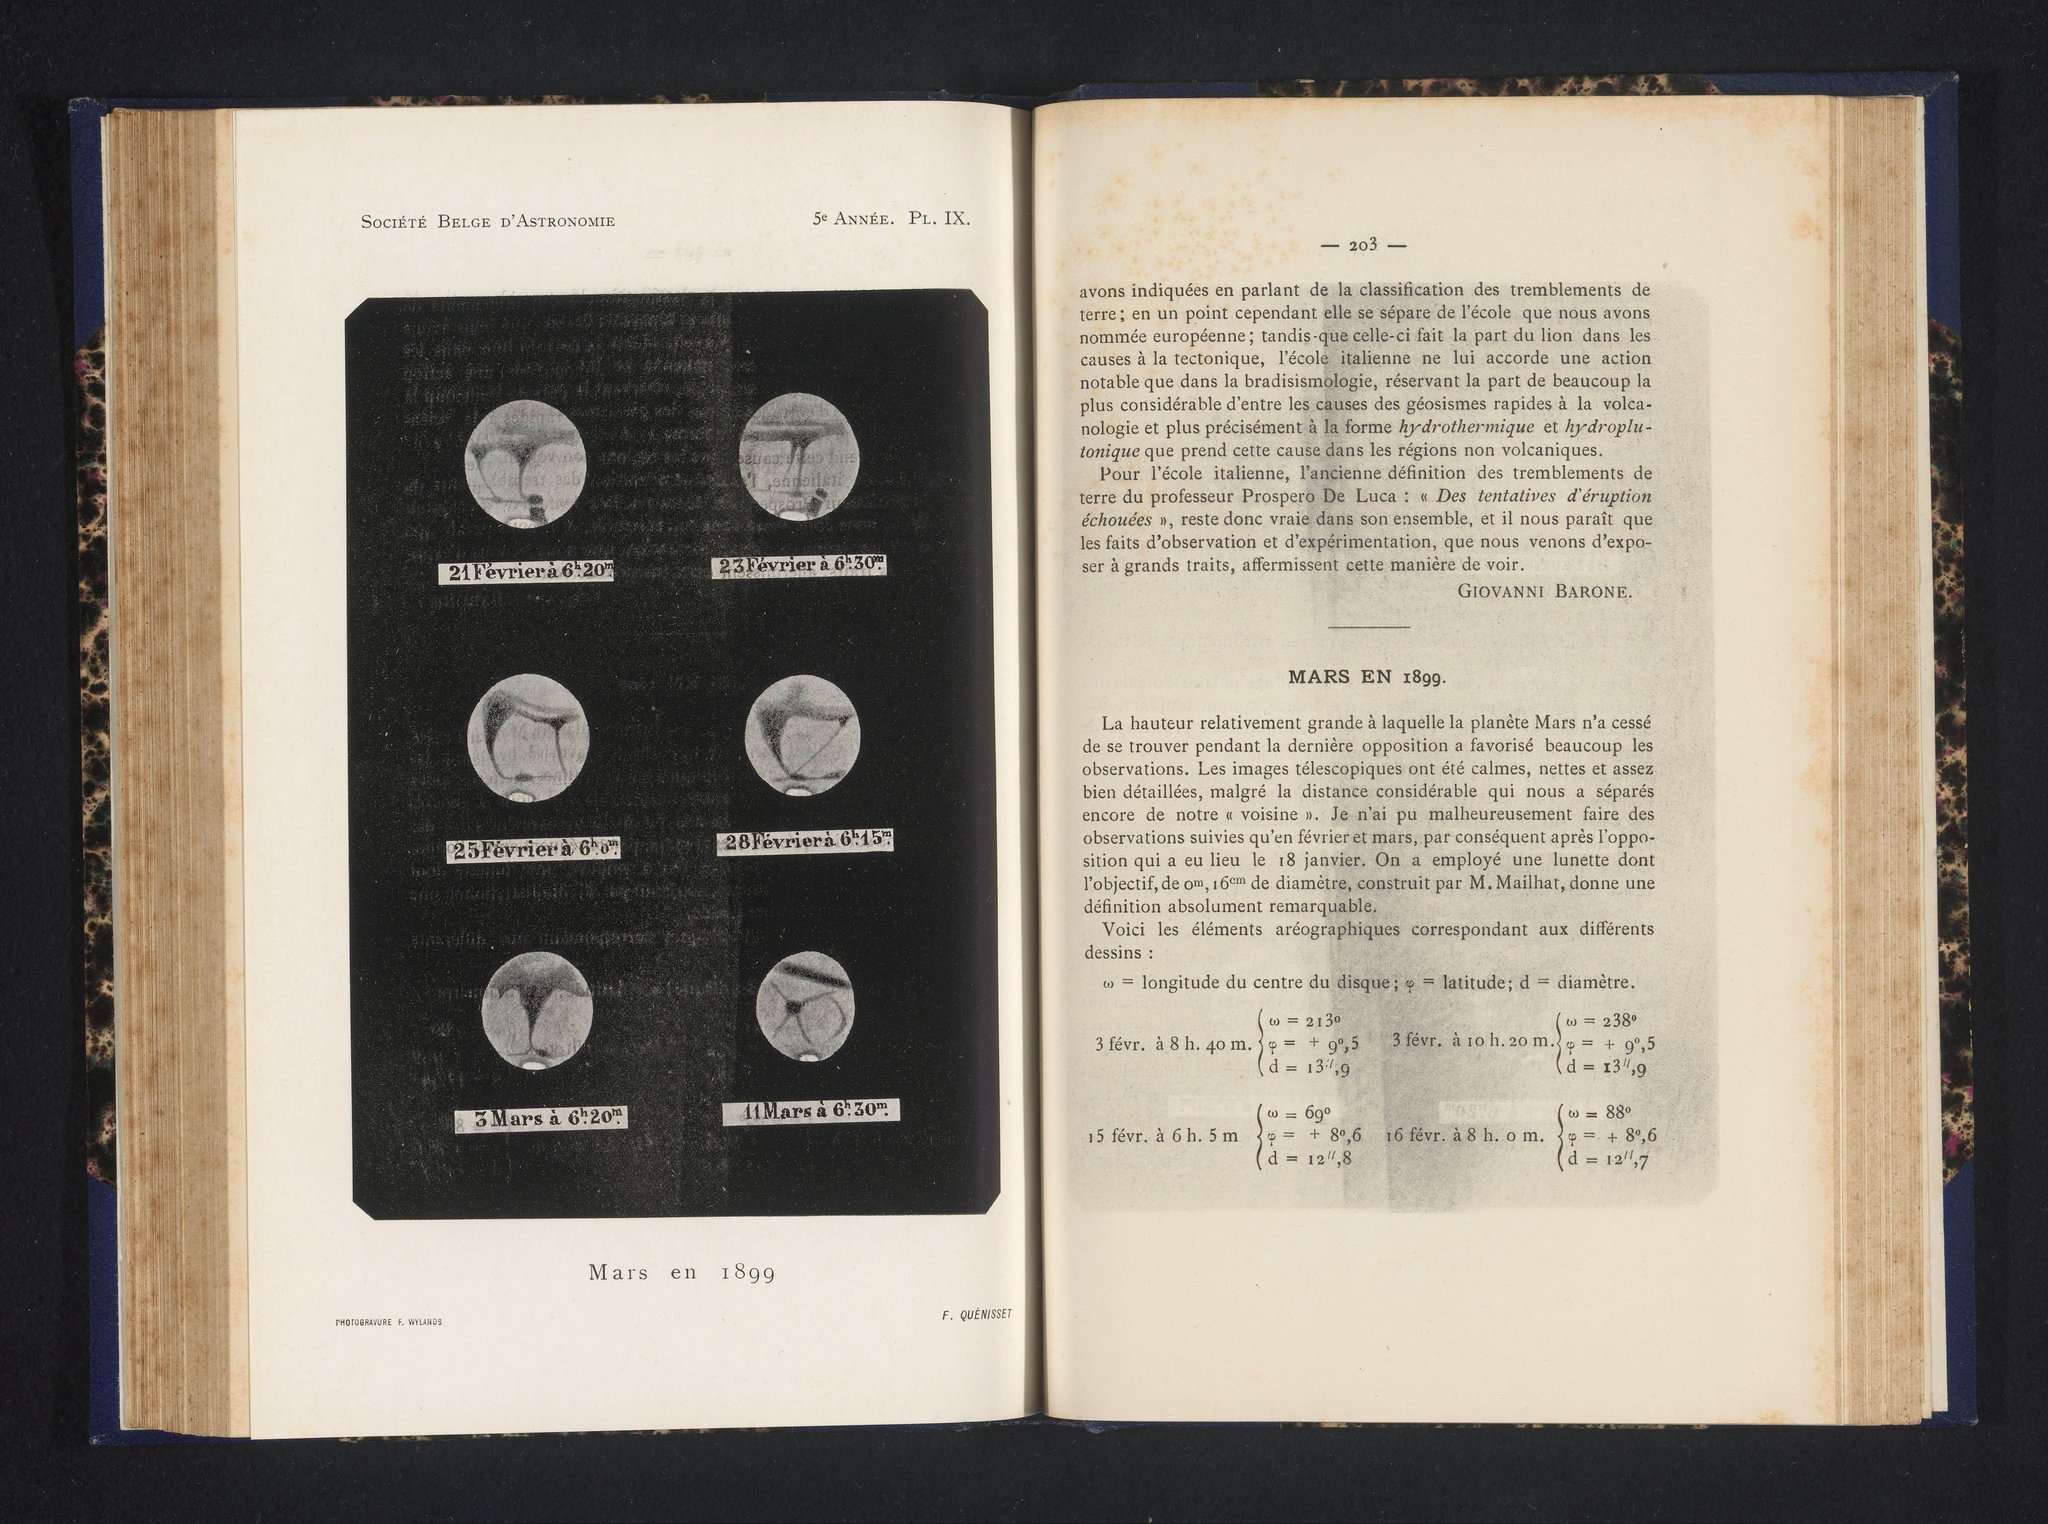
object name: page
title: Zes gezichten op Mars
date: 1899-1900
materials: paper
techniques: autotype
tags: mars (planet)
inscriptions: inscription: ‘5e année. Pl. IX.’